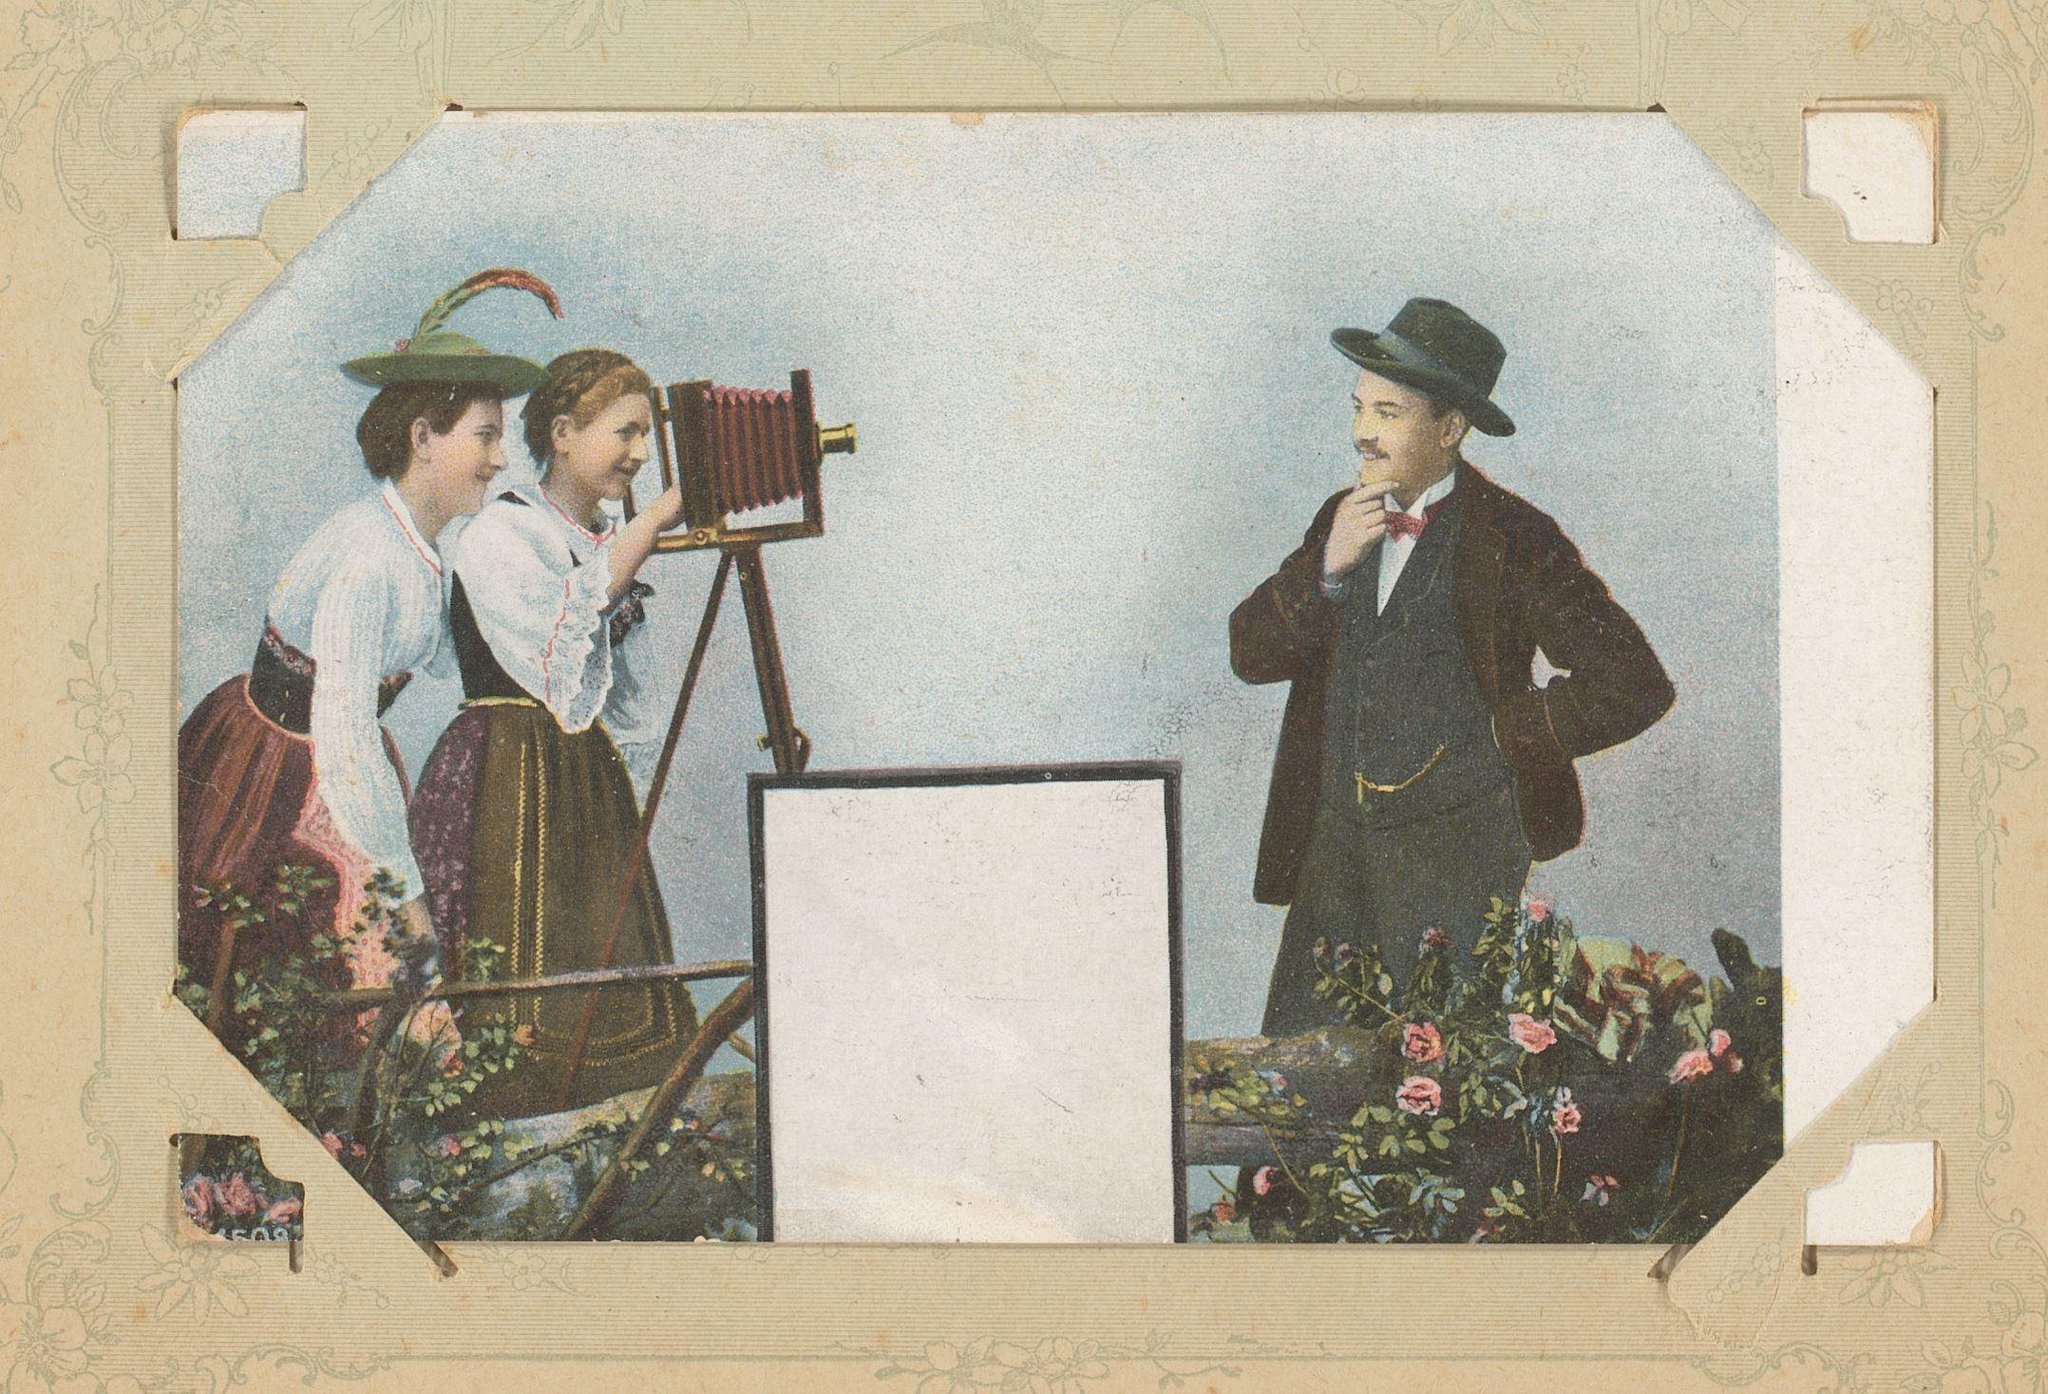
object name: ansichtkaart, prentbriefkaart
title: Twee vrouwen bij een camera en een poserende man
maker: Anonymous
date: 1900-1950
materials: cardboard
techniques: four-color autotype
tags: flowers, adult woman, photography, adult man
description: Deze prent maakt deel uit van een album.